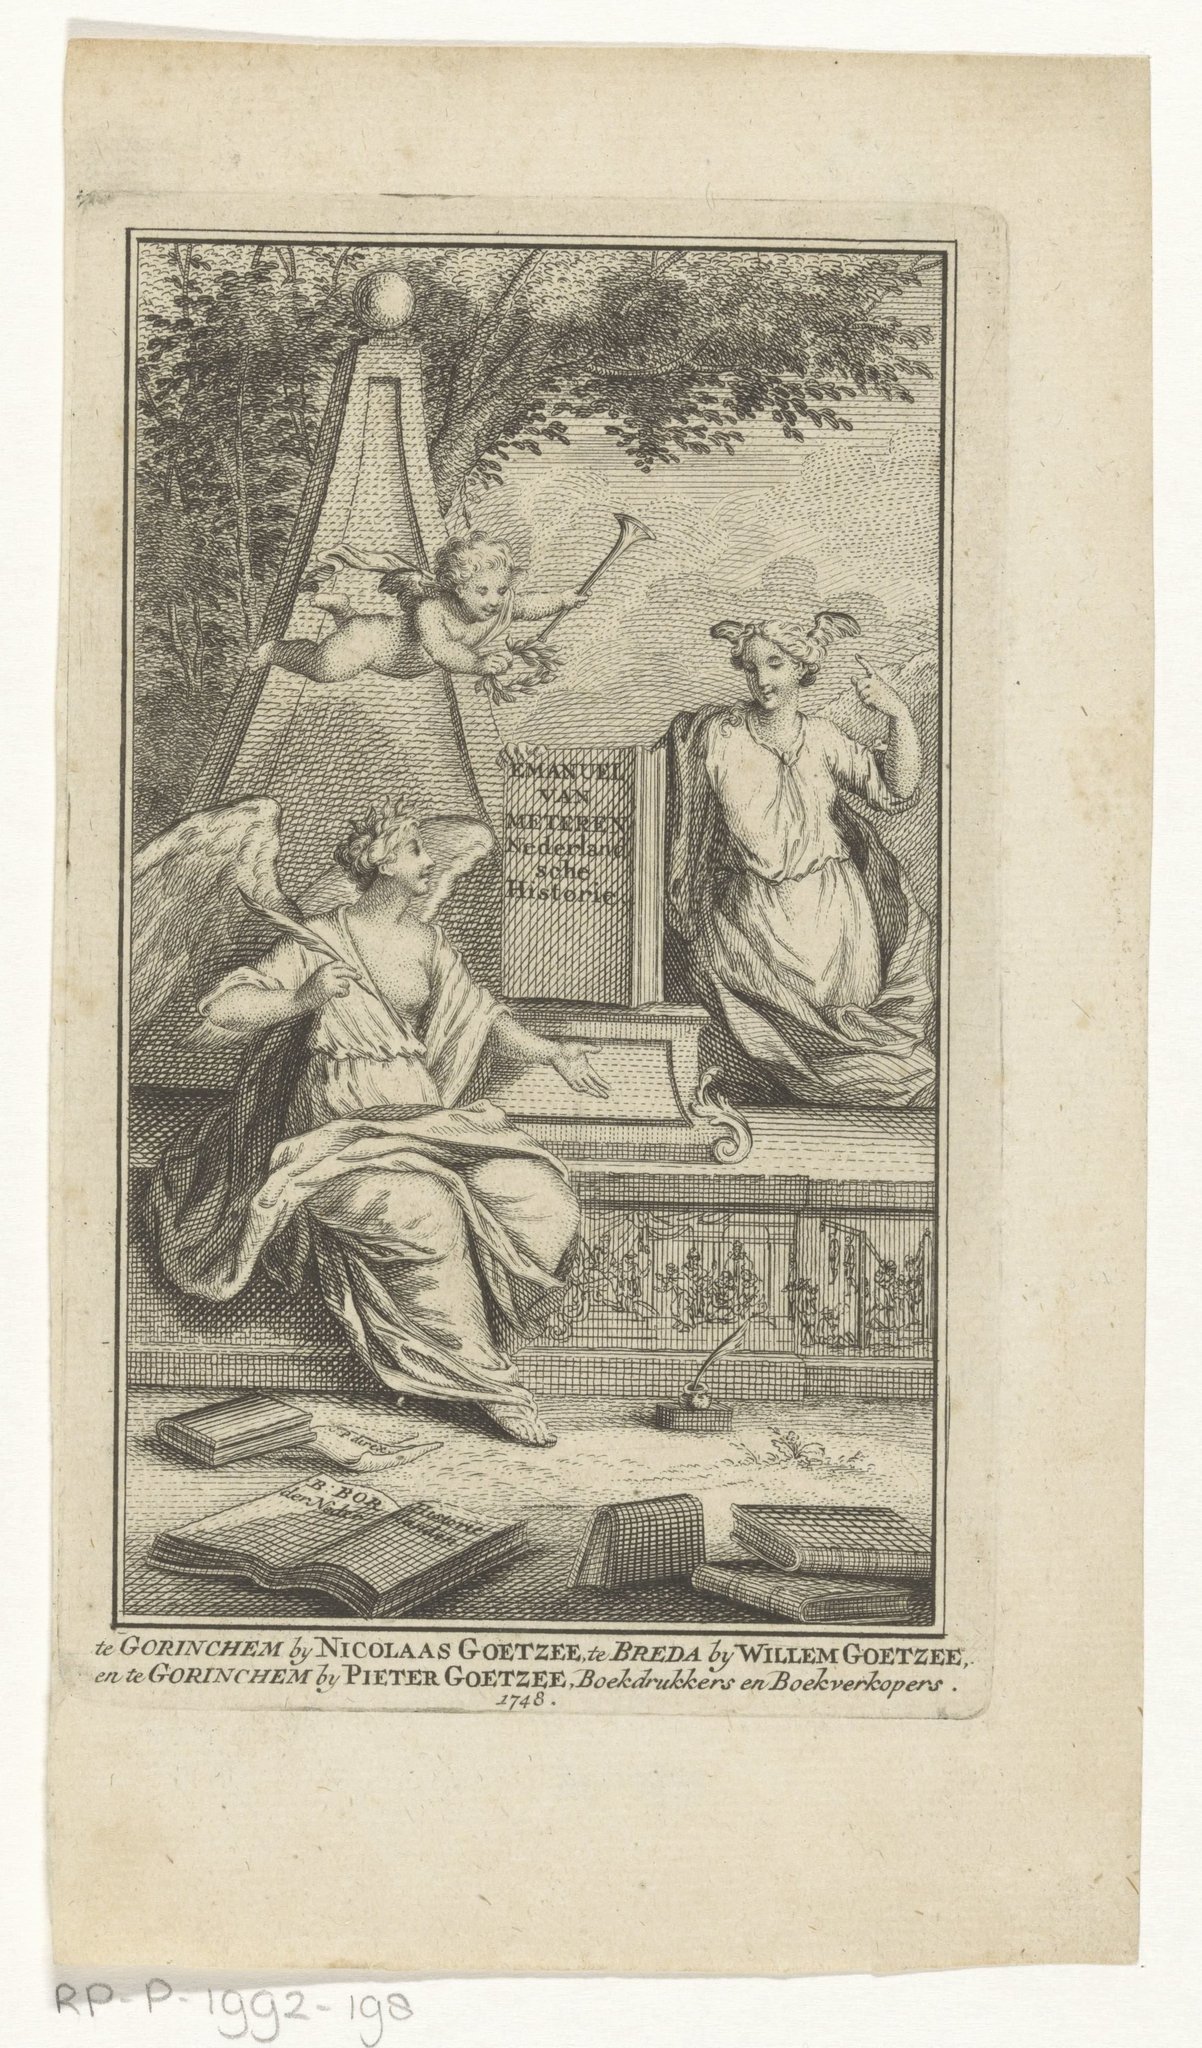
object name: print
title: Emanuel van Meteren Nederlandsche Historie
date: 1748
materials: paper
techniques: etching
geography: gorinchem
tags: antwerp, emanuel van meteren, book, 'historia'; 'historia' (ripa)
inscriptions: collector's mark: Lugt 2760, collector's mark: Lugt 2228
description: Een vrouw met vleugels aan het hoofd presenteert het boek van Emanuel van Meteren aan de zittende Geschiedenis met schrijfveer in de hand. Een putto met bazuin en lauwerkrans vliegt boven het boek. Op de voorgrond liggen boeken.